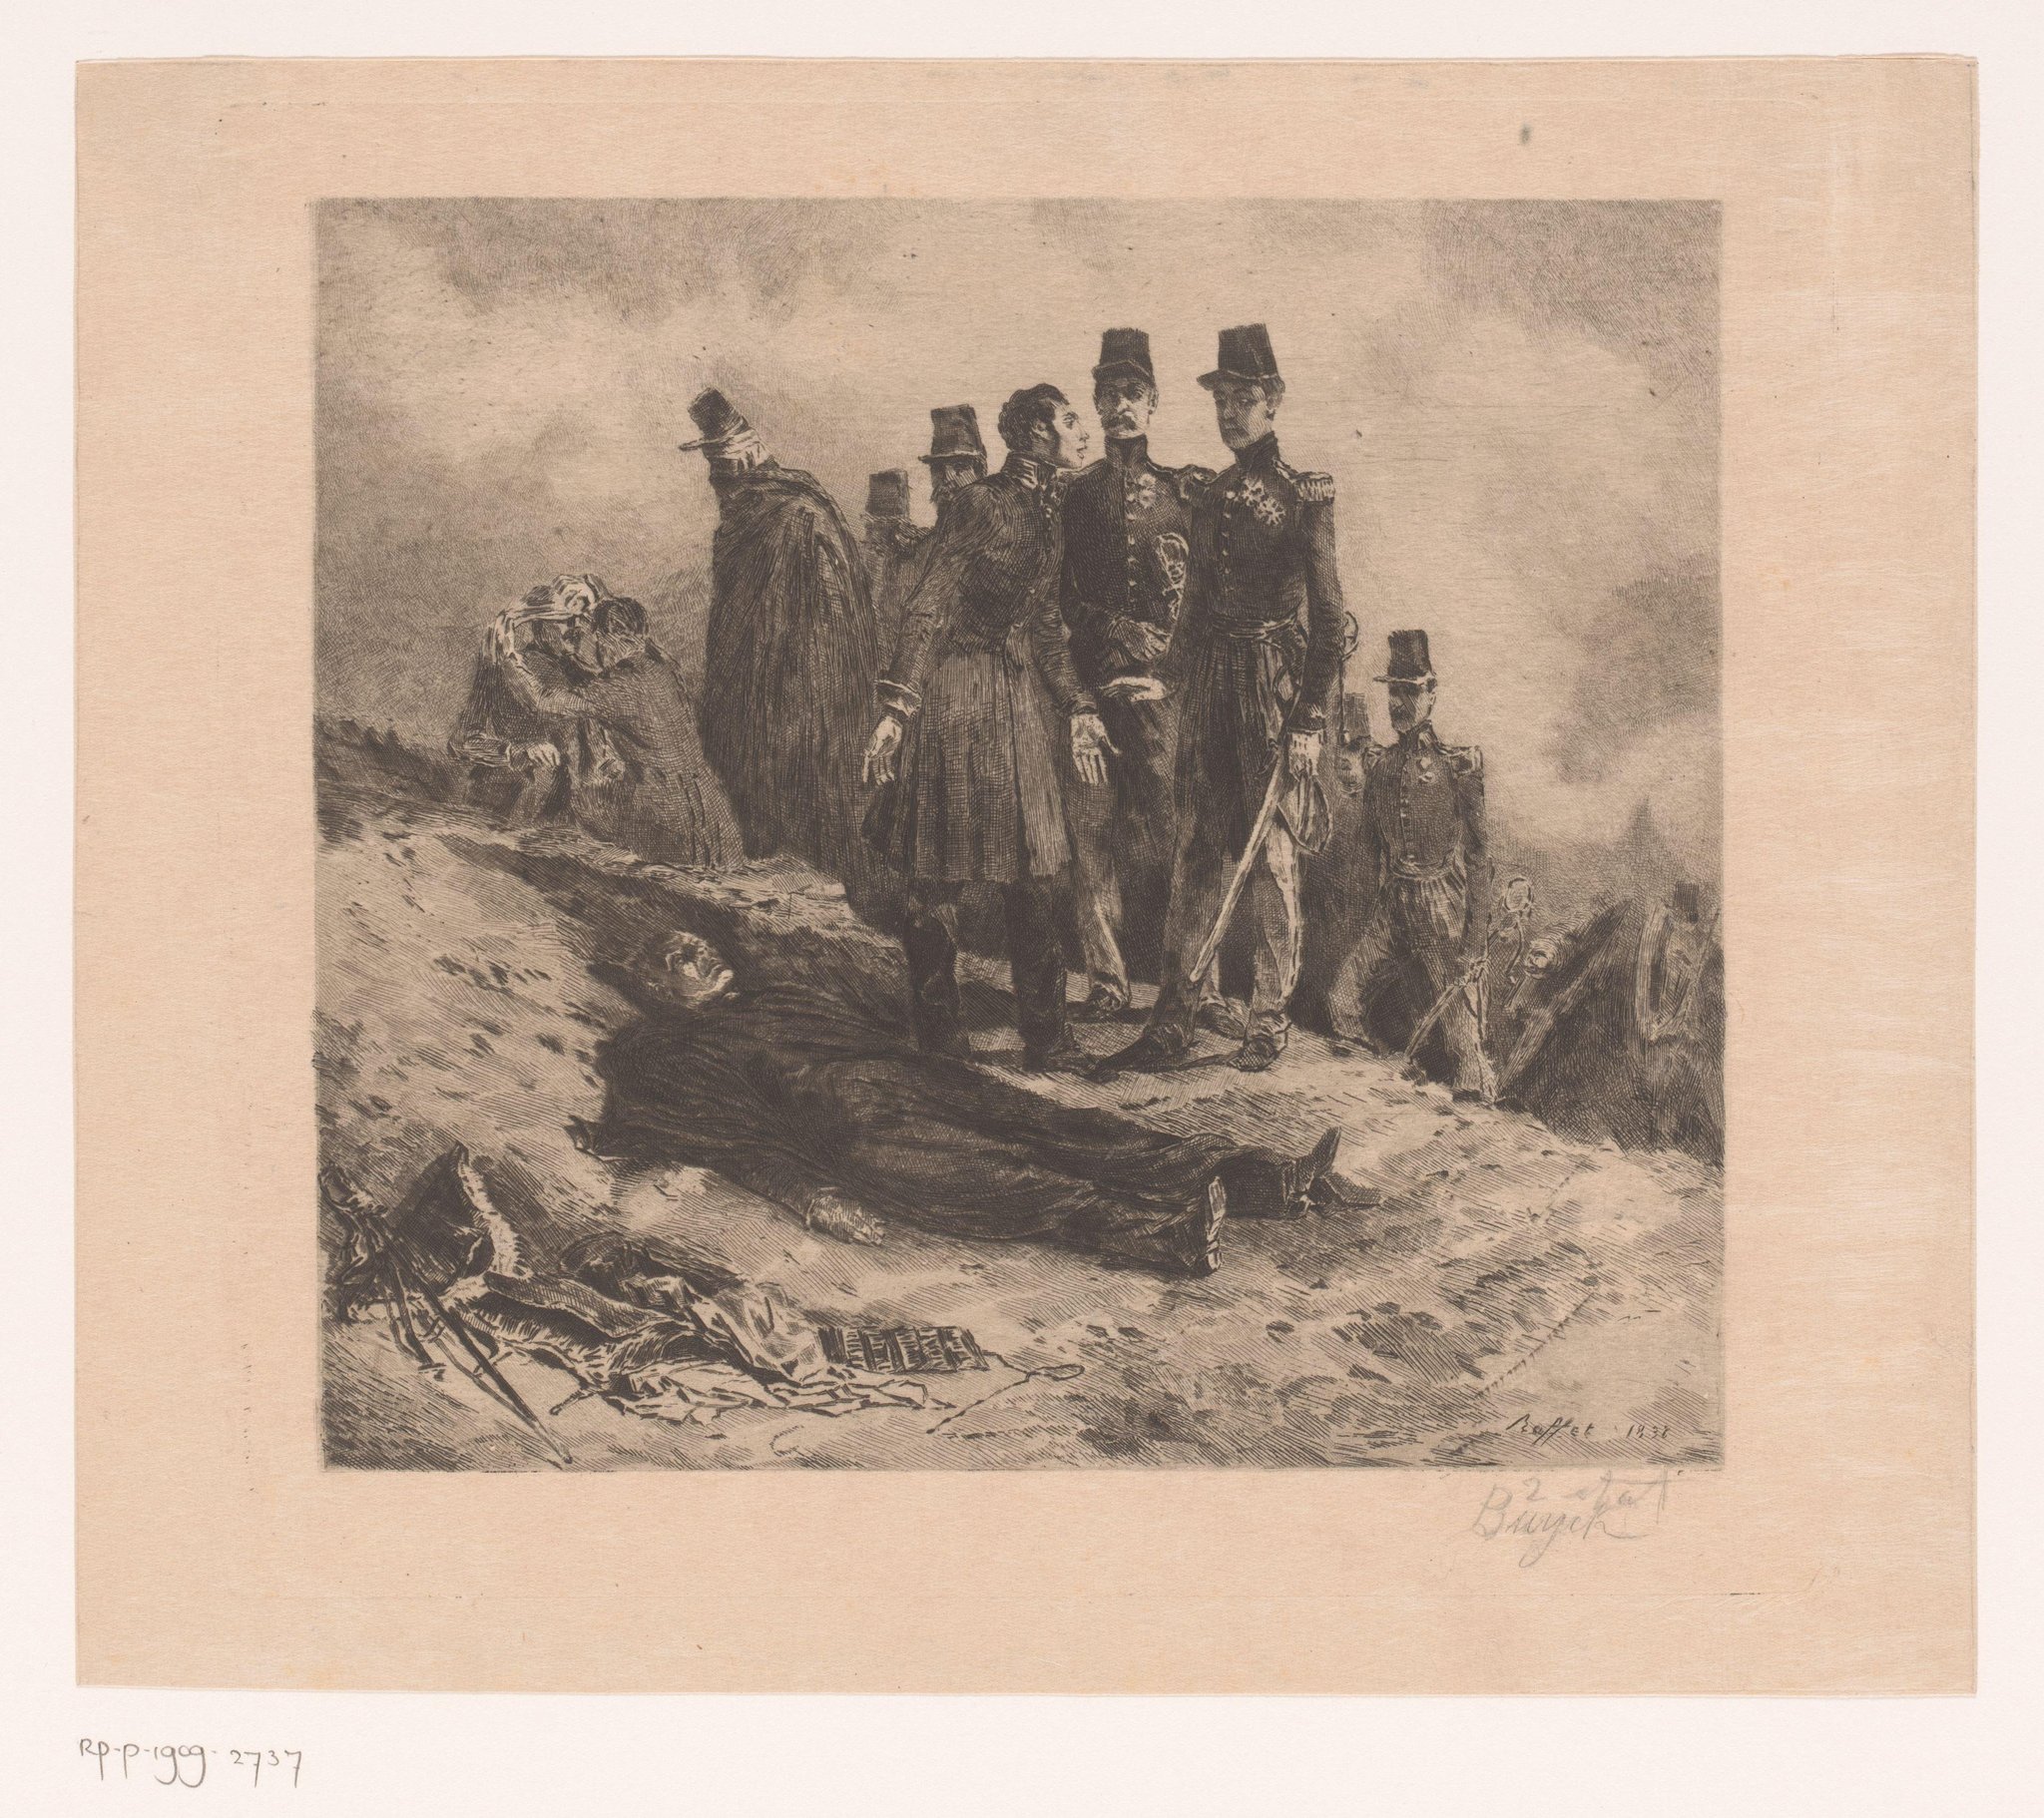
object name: print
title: Dood op het slagveld van Generaal Ambremont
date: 1888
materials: paper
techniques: etching, intaglio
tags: the corpse, the defeated (after the battle)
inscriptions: annotation: ‘2 etat’, collector's mark: Lugt 2228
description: Sterfdatum prentmaker onbekend. Derhalve is voor bepaling van de rechten van dit object de verwervingsdatum aangehouden.